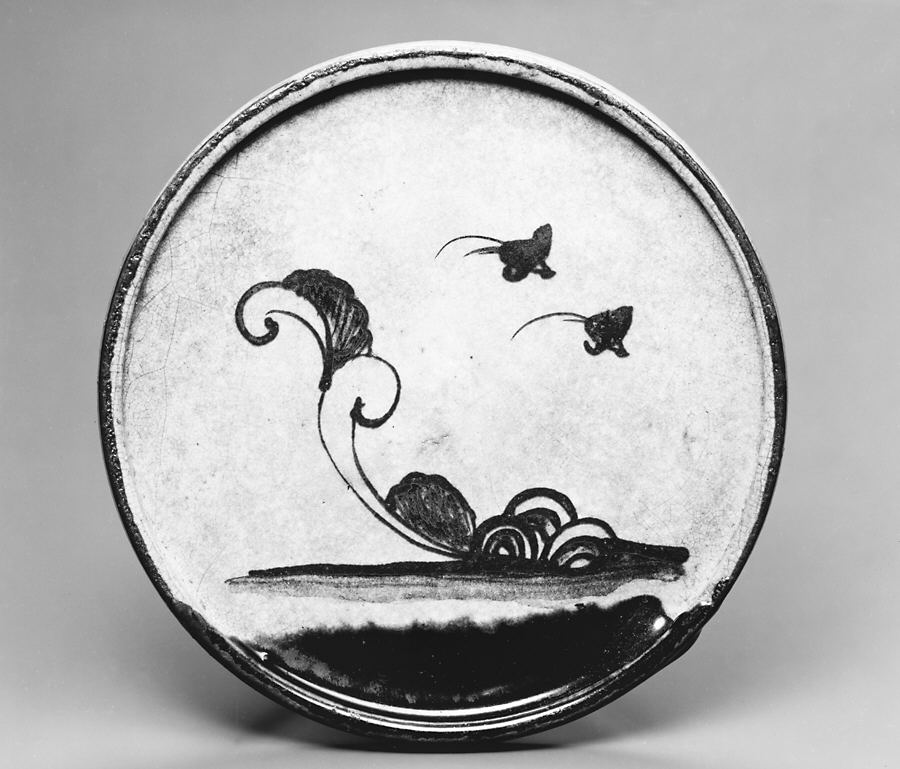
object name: plate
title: Plate with Floral and Other Designs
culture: japanese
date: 1801-1833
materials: stoneware